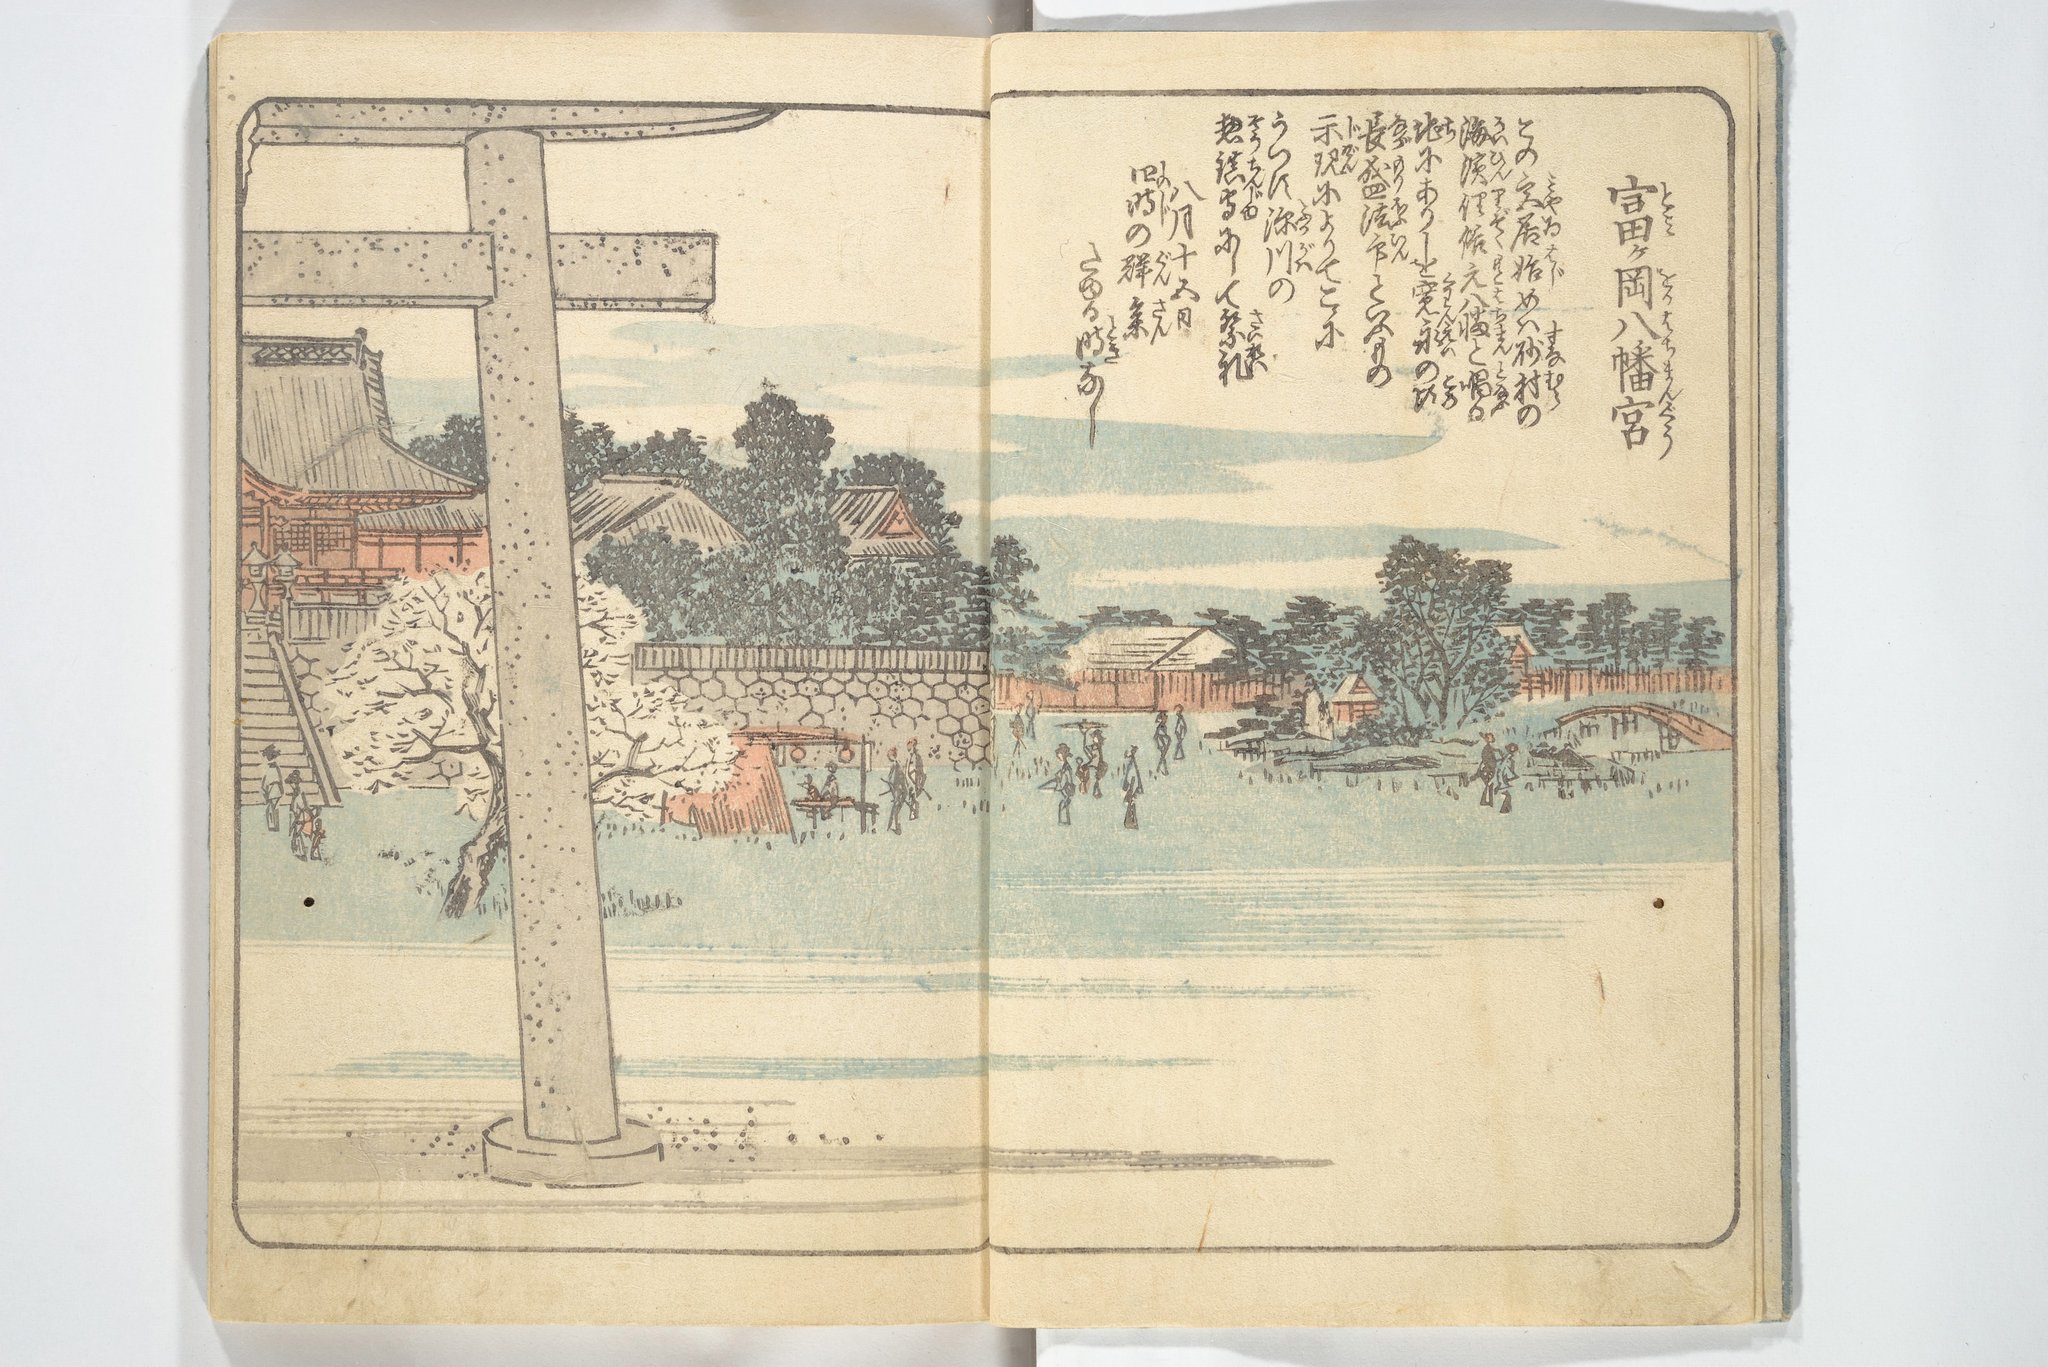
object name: illustrated book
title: Picture Book of the Souvenirs of Edo (Ehon Edo miyage) 絵本江戸土産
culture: japanese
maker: utagawa hiroshige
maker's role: artist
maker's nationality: japanese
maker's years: 1797-1858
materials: ink, paper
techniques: woodblock print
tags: human figures,houses